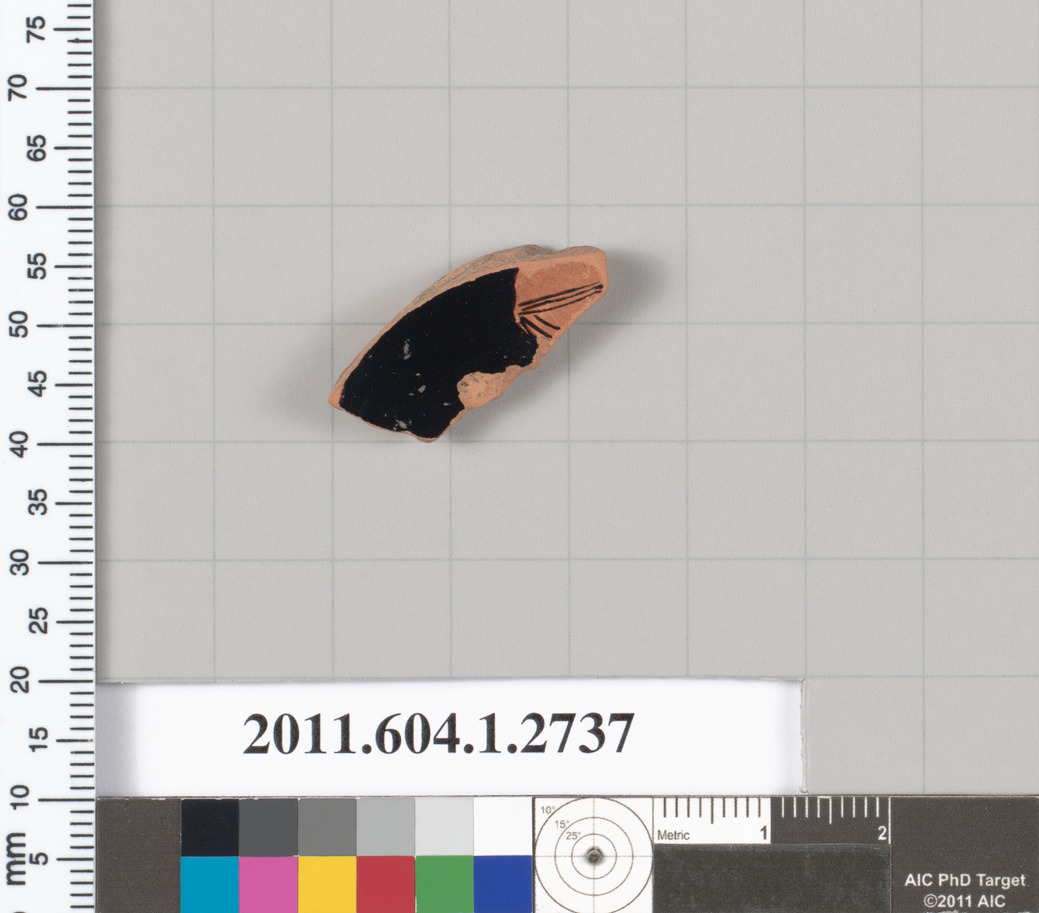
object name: kylix fragment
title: Terracotta fragment of a kylix (drinking cup)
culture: greek, attic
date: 475-451 BCE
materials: terracotta